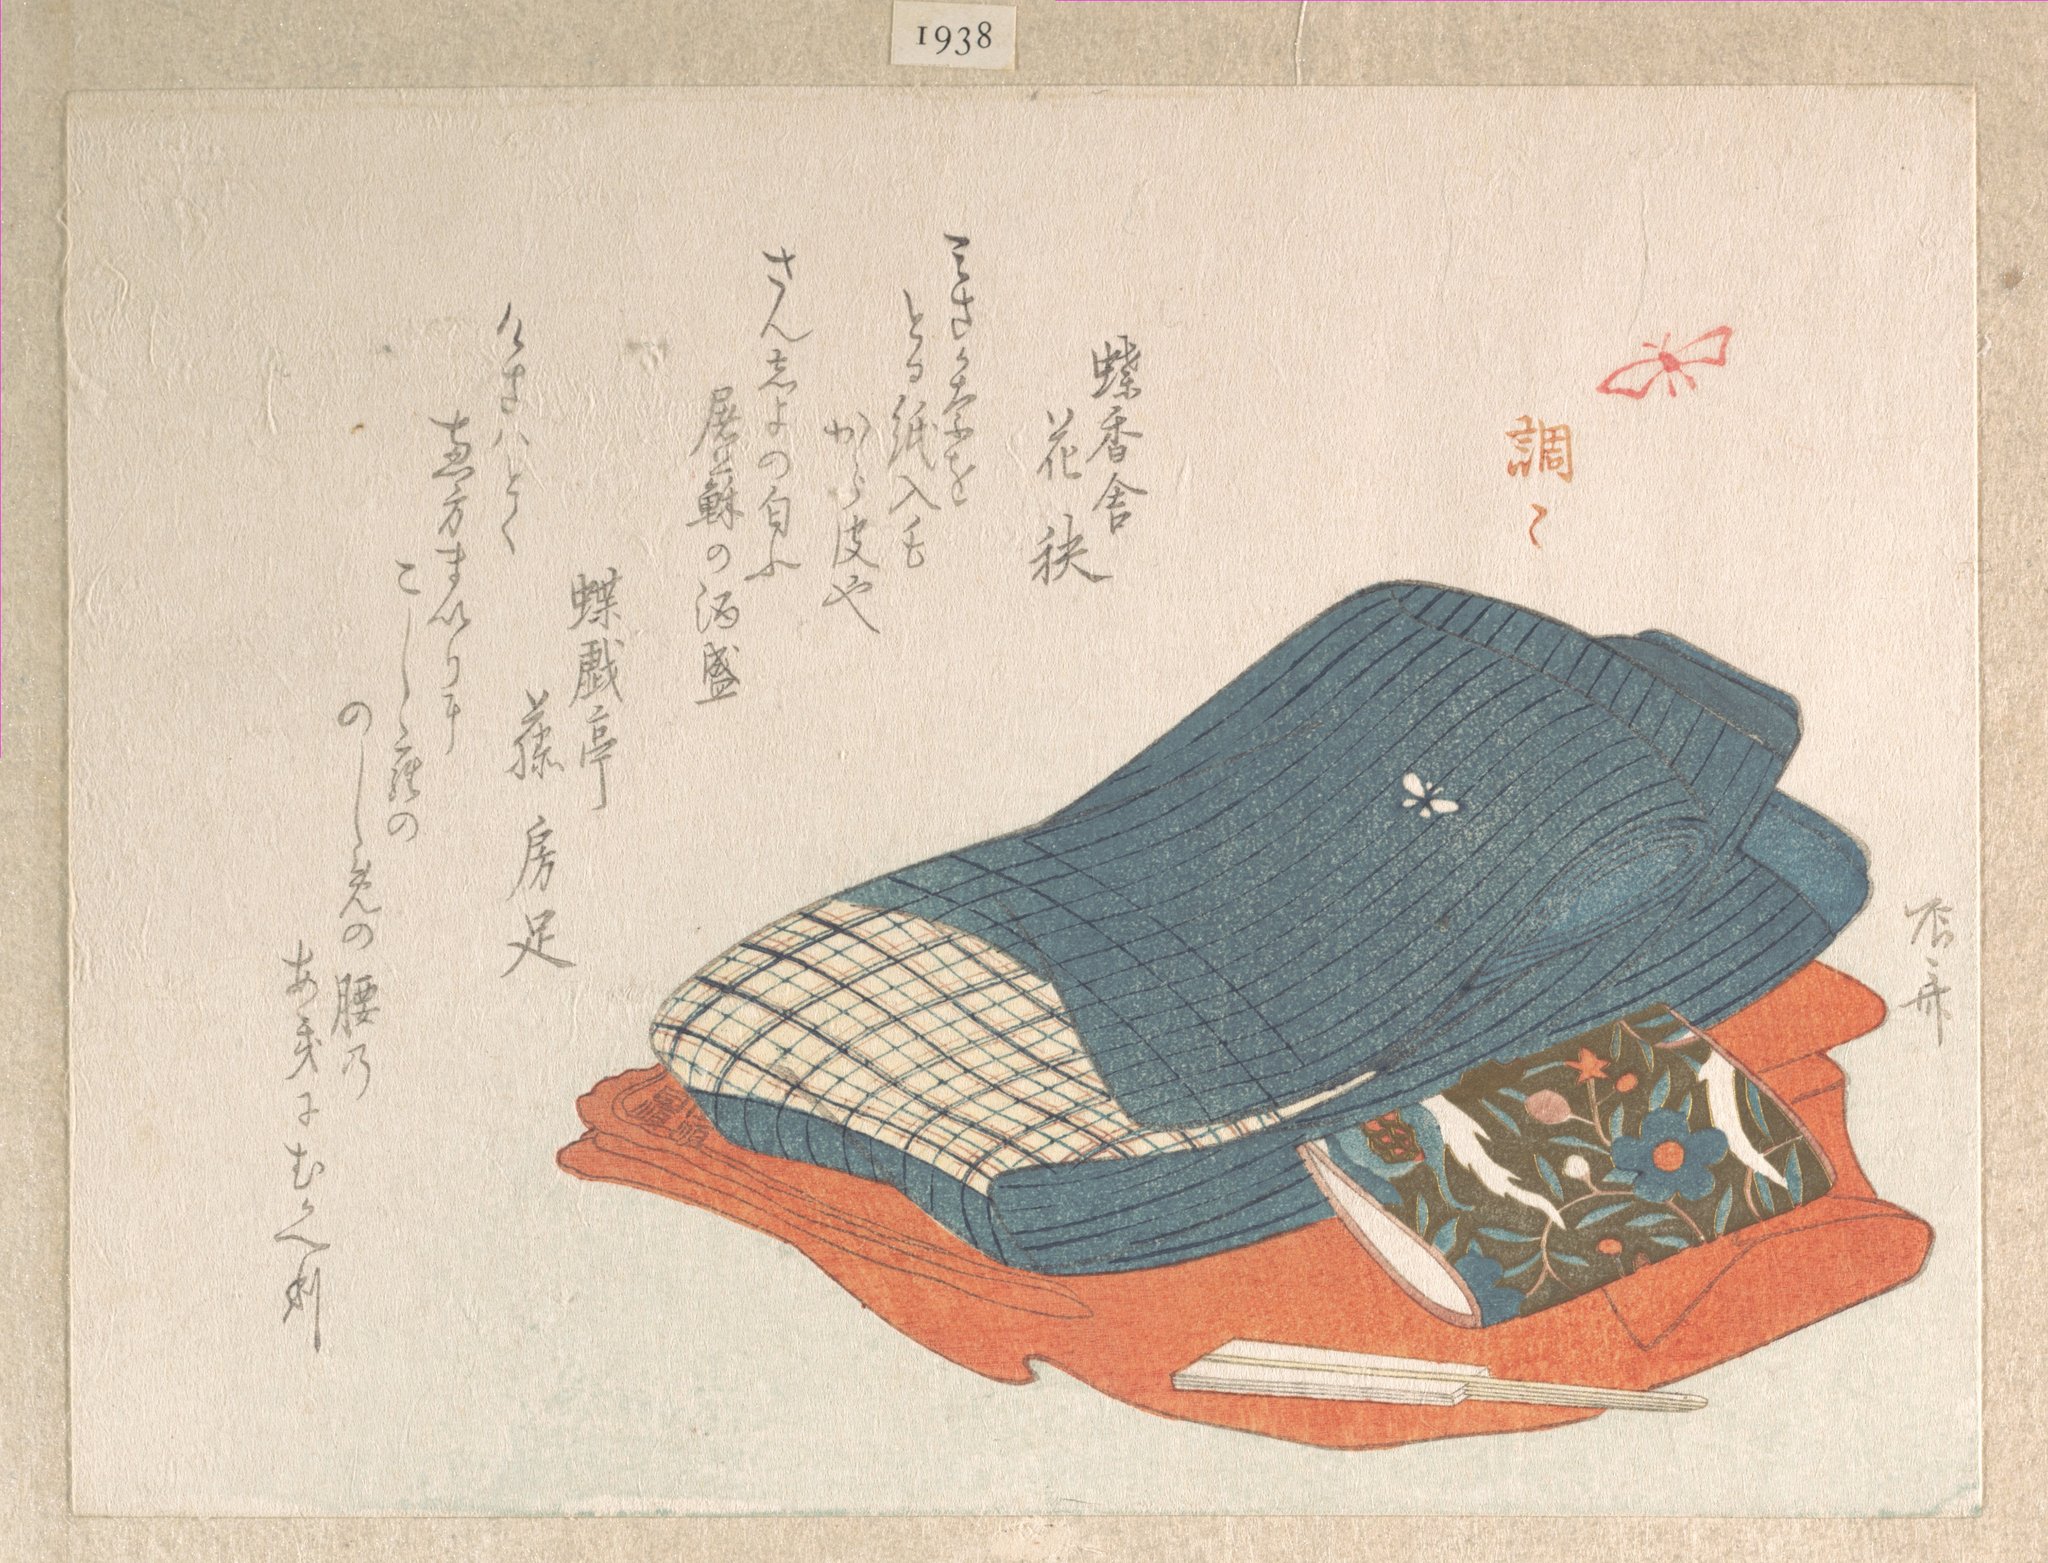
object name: woodblock print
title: Bed-clothing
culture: japanese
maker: ryūryūkyo shinsai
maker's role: artist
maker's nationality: japanese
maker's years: 1799-1823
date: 1750-1835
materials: ink, paper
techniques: surimono, woodblock print